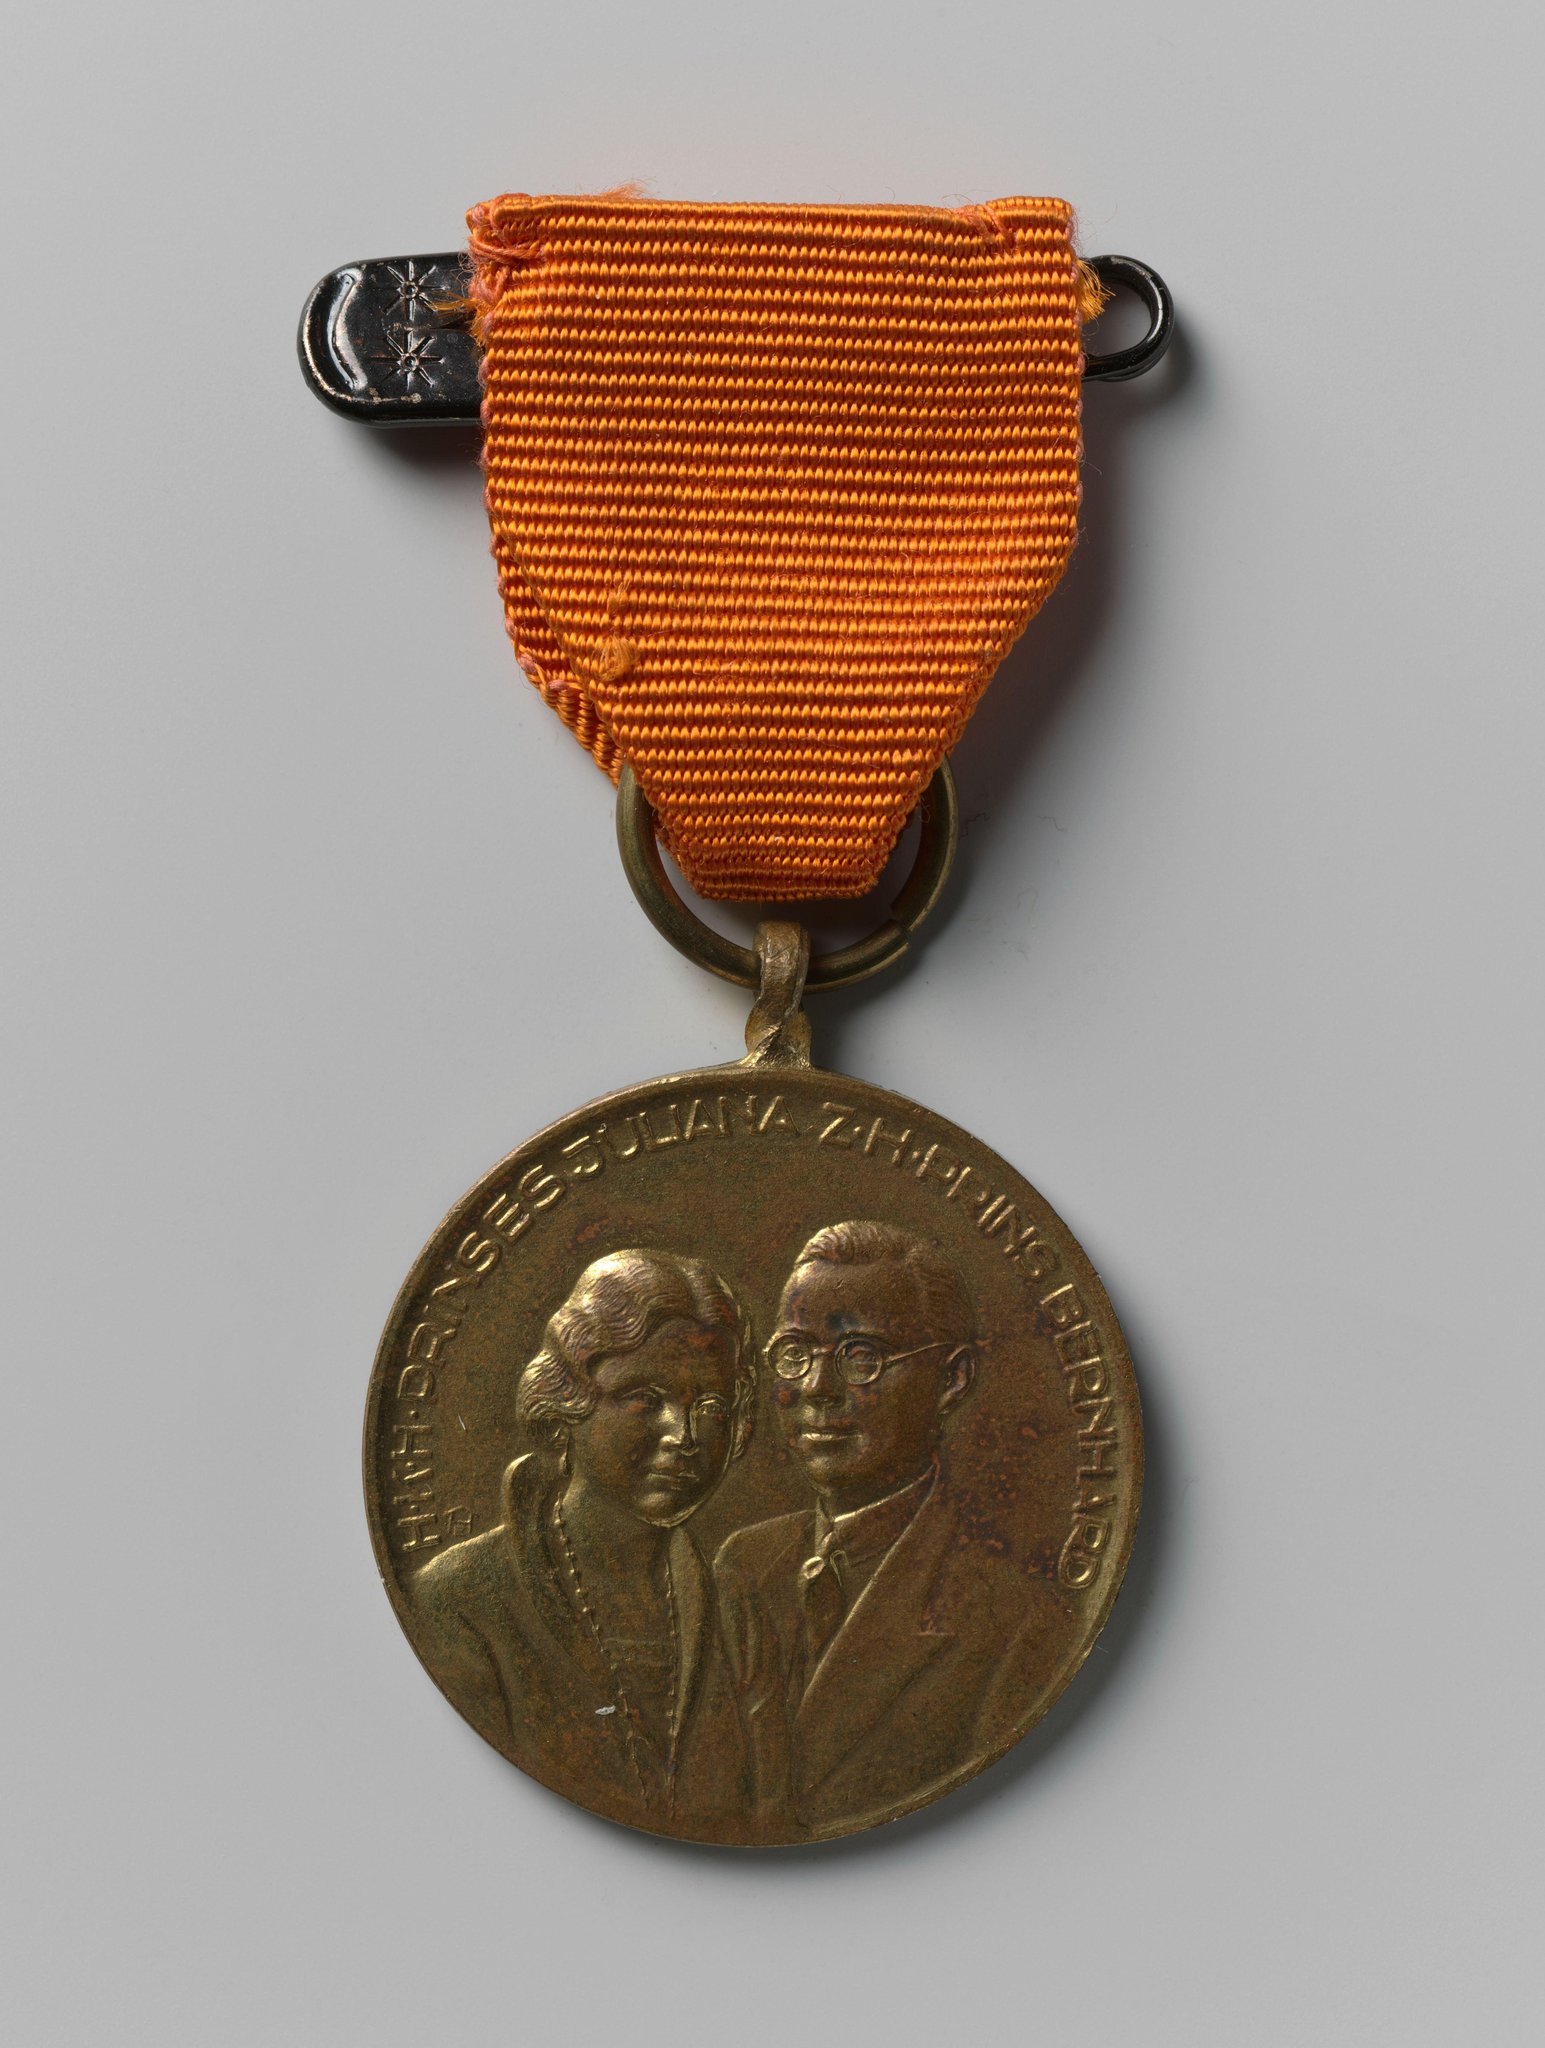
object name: insignia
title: Draagpenning op de verloving van Prinses Juliana met Bernhard 1936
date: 1936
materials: brass, textile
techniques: striking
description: Vergulde penning met oog en draagring aan een oranje lint met veilgheidsspeld, op de voorzijde de elkaar half toegewende borstbeelden van Juliana en Bernhard met bovenaan omschrift, op de keerzijde twee wapenschilden tegen een oranjeboom met één regel tekst.